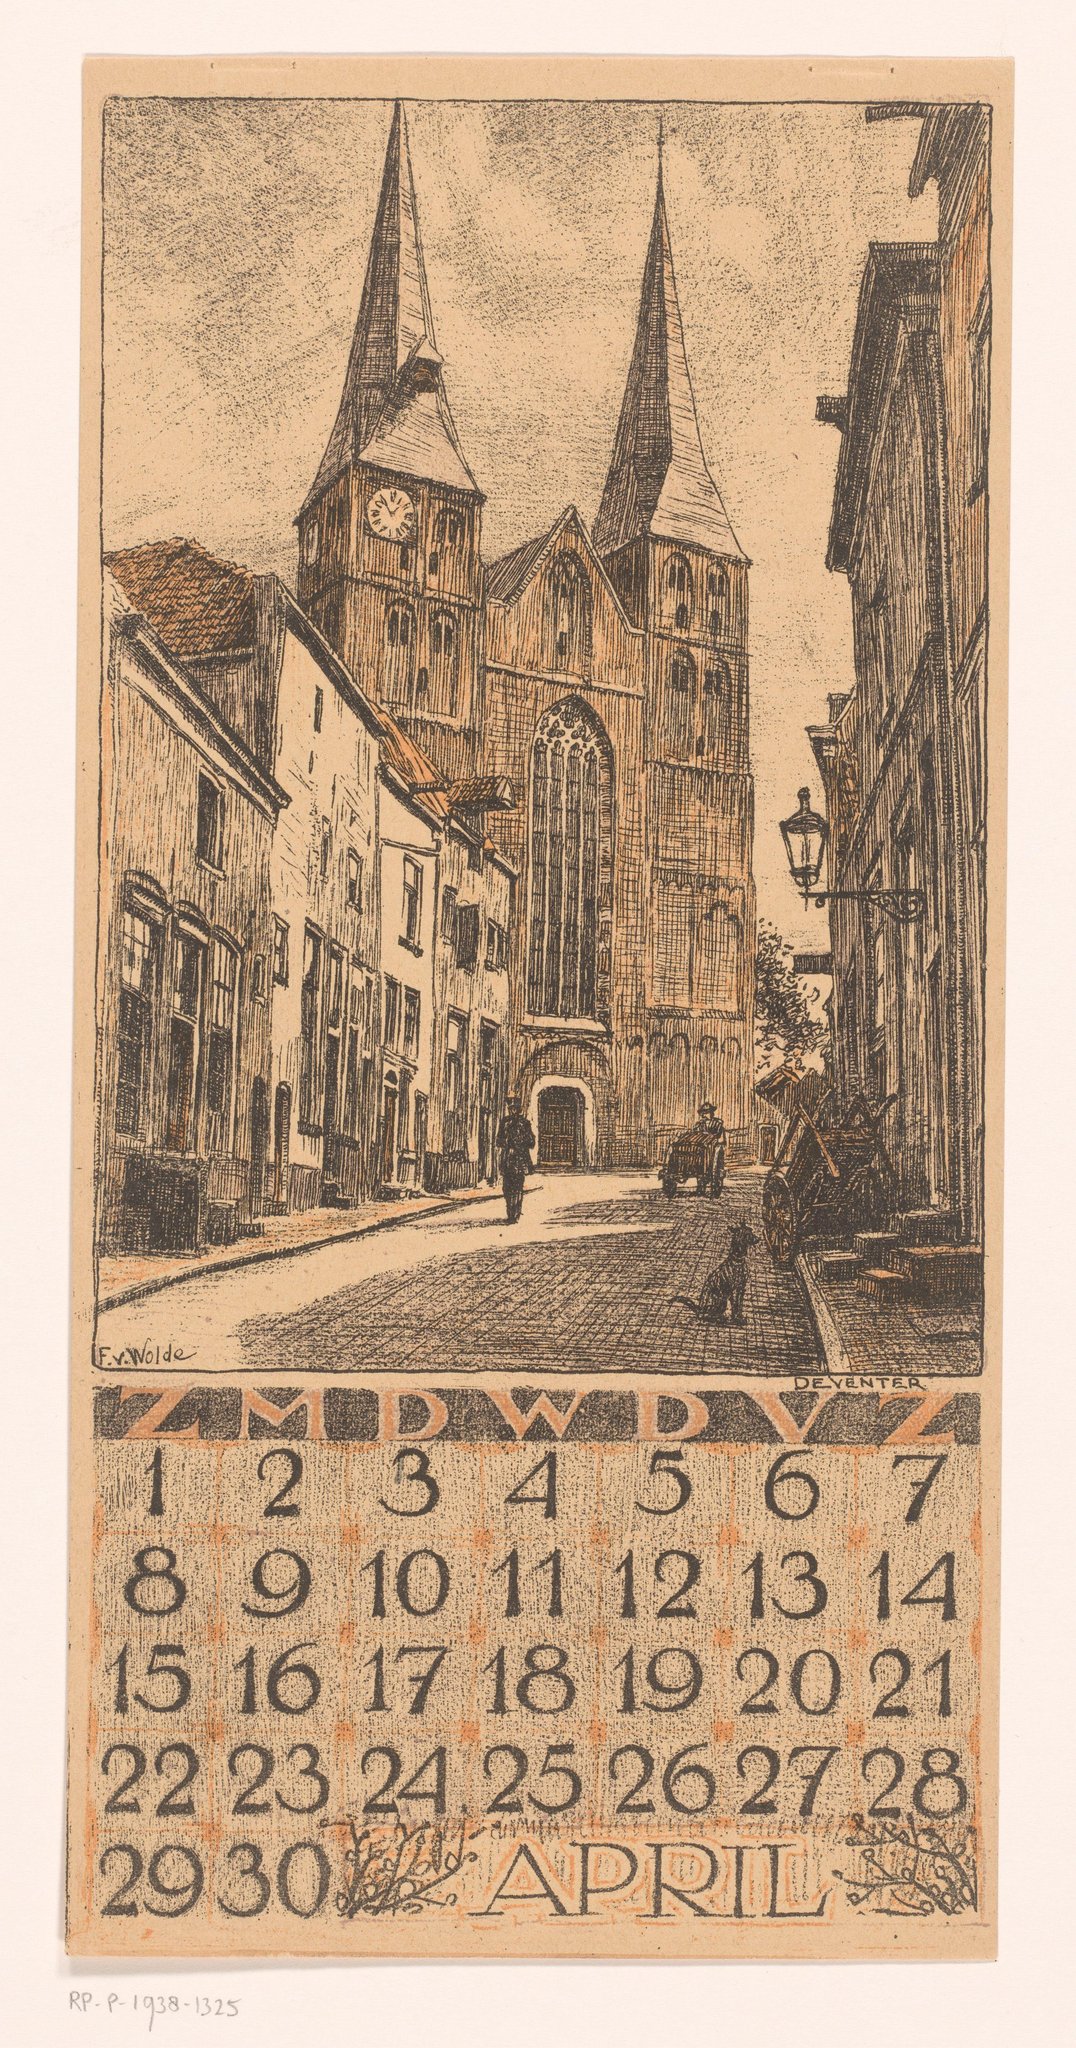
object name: print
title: Kalenderblad april met stadsgezicht in Deventer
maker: ferdinand van wolde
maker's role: print maker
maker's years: 1891-1945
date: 1923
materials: paper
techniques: lithograph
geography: netherlands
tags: church (exterior), april ~ other concepts, street (+ city(-scape) with figures, staffage)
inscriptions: collector's mark: Lugt 2760, collector's mark: Lugt 2228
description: Gezicht op de Sint-Nicolaas- of Bergkerk.